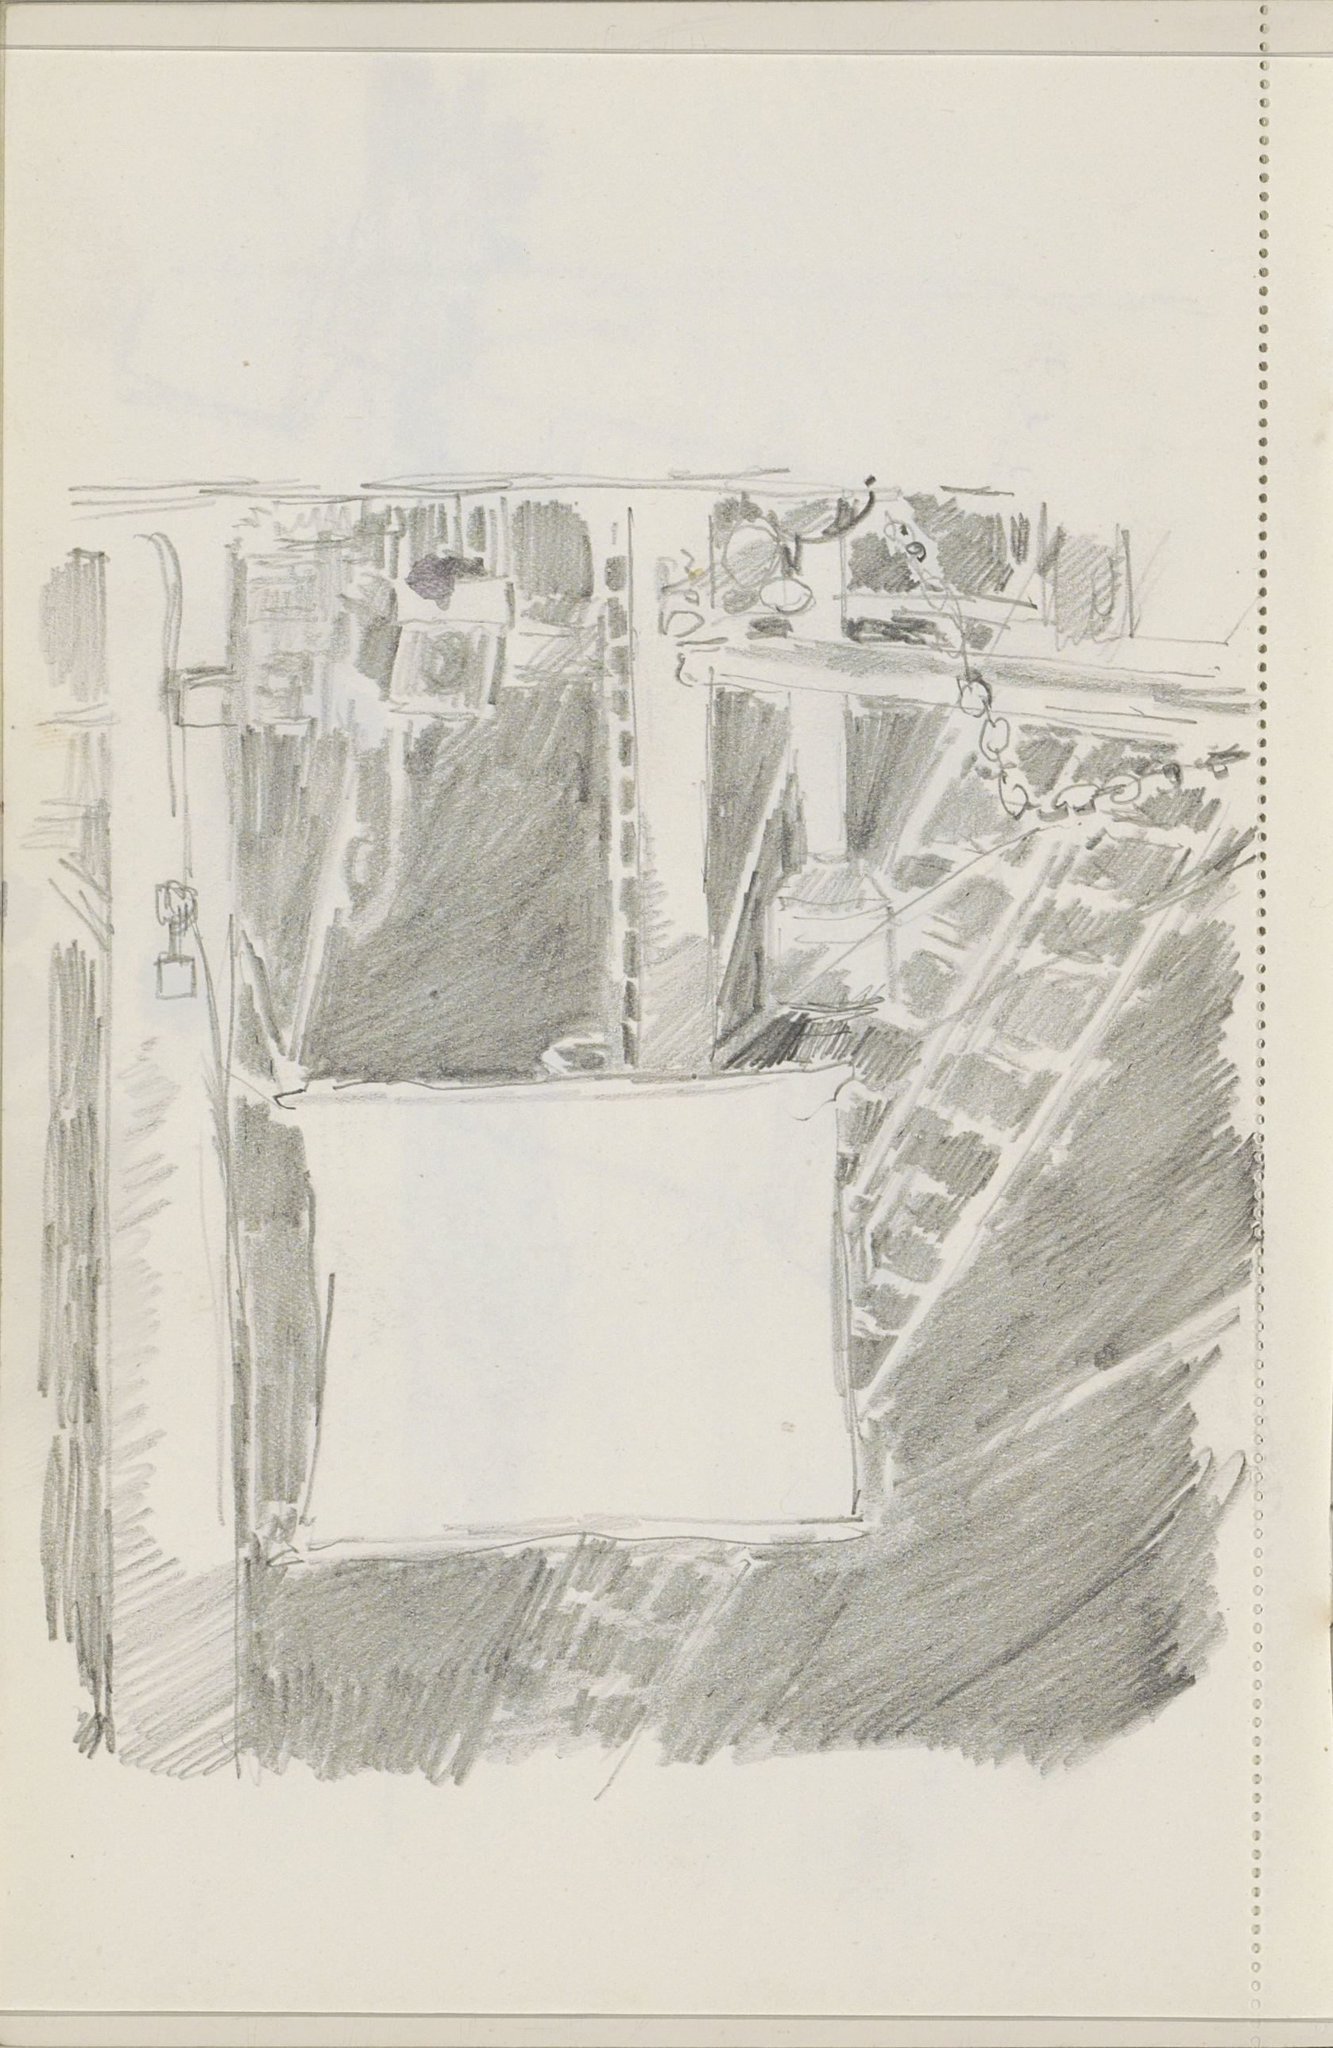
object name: sketchbook leaf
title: Mast van een zeilschip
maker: cornelis vreedenburgh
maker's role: draughtsman, print maker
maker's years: 1880-1946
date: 1936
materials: paper, pencil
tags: parts of ship's exterior: mast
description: Blad 24 verso uit een schetsboek met 73 bladen.